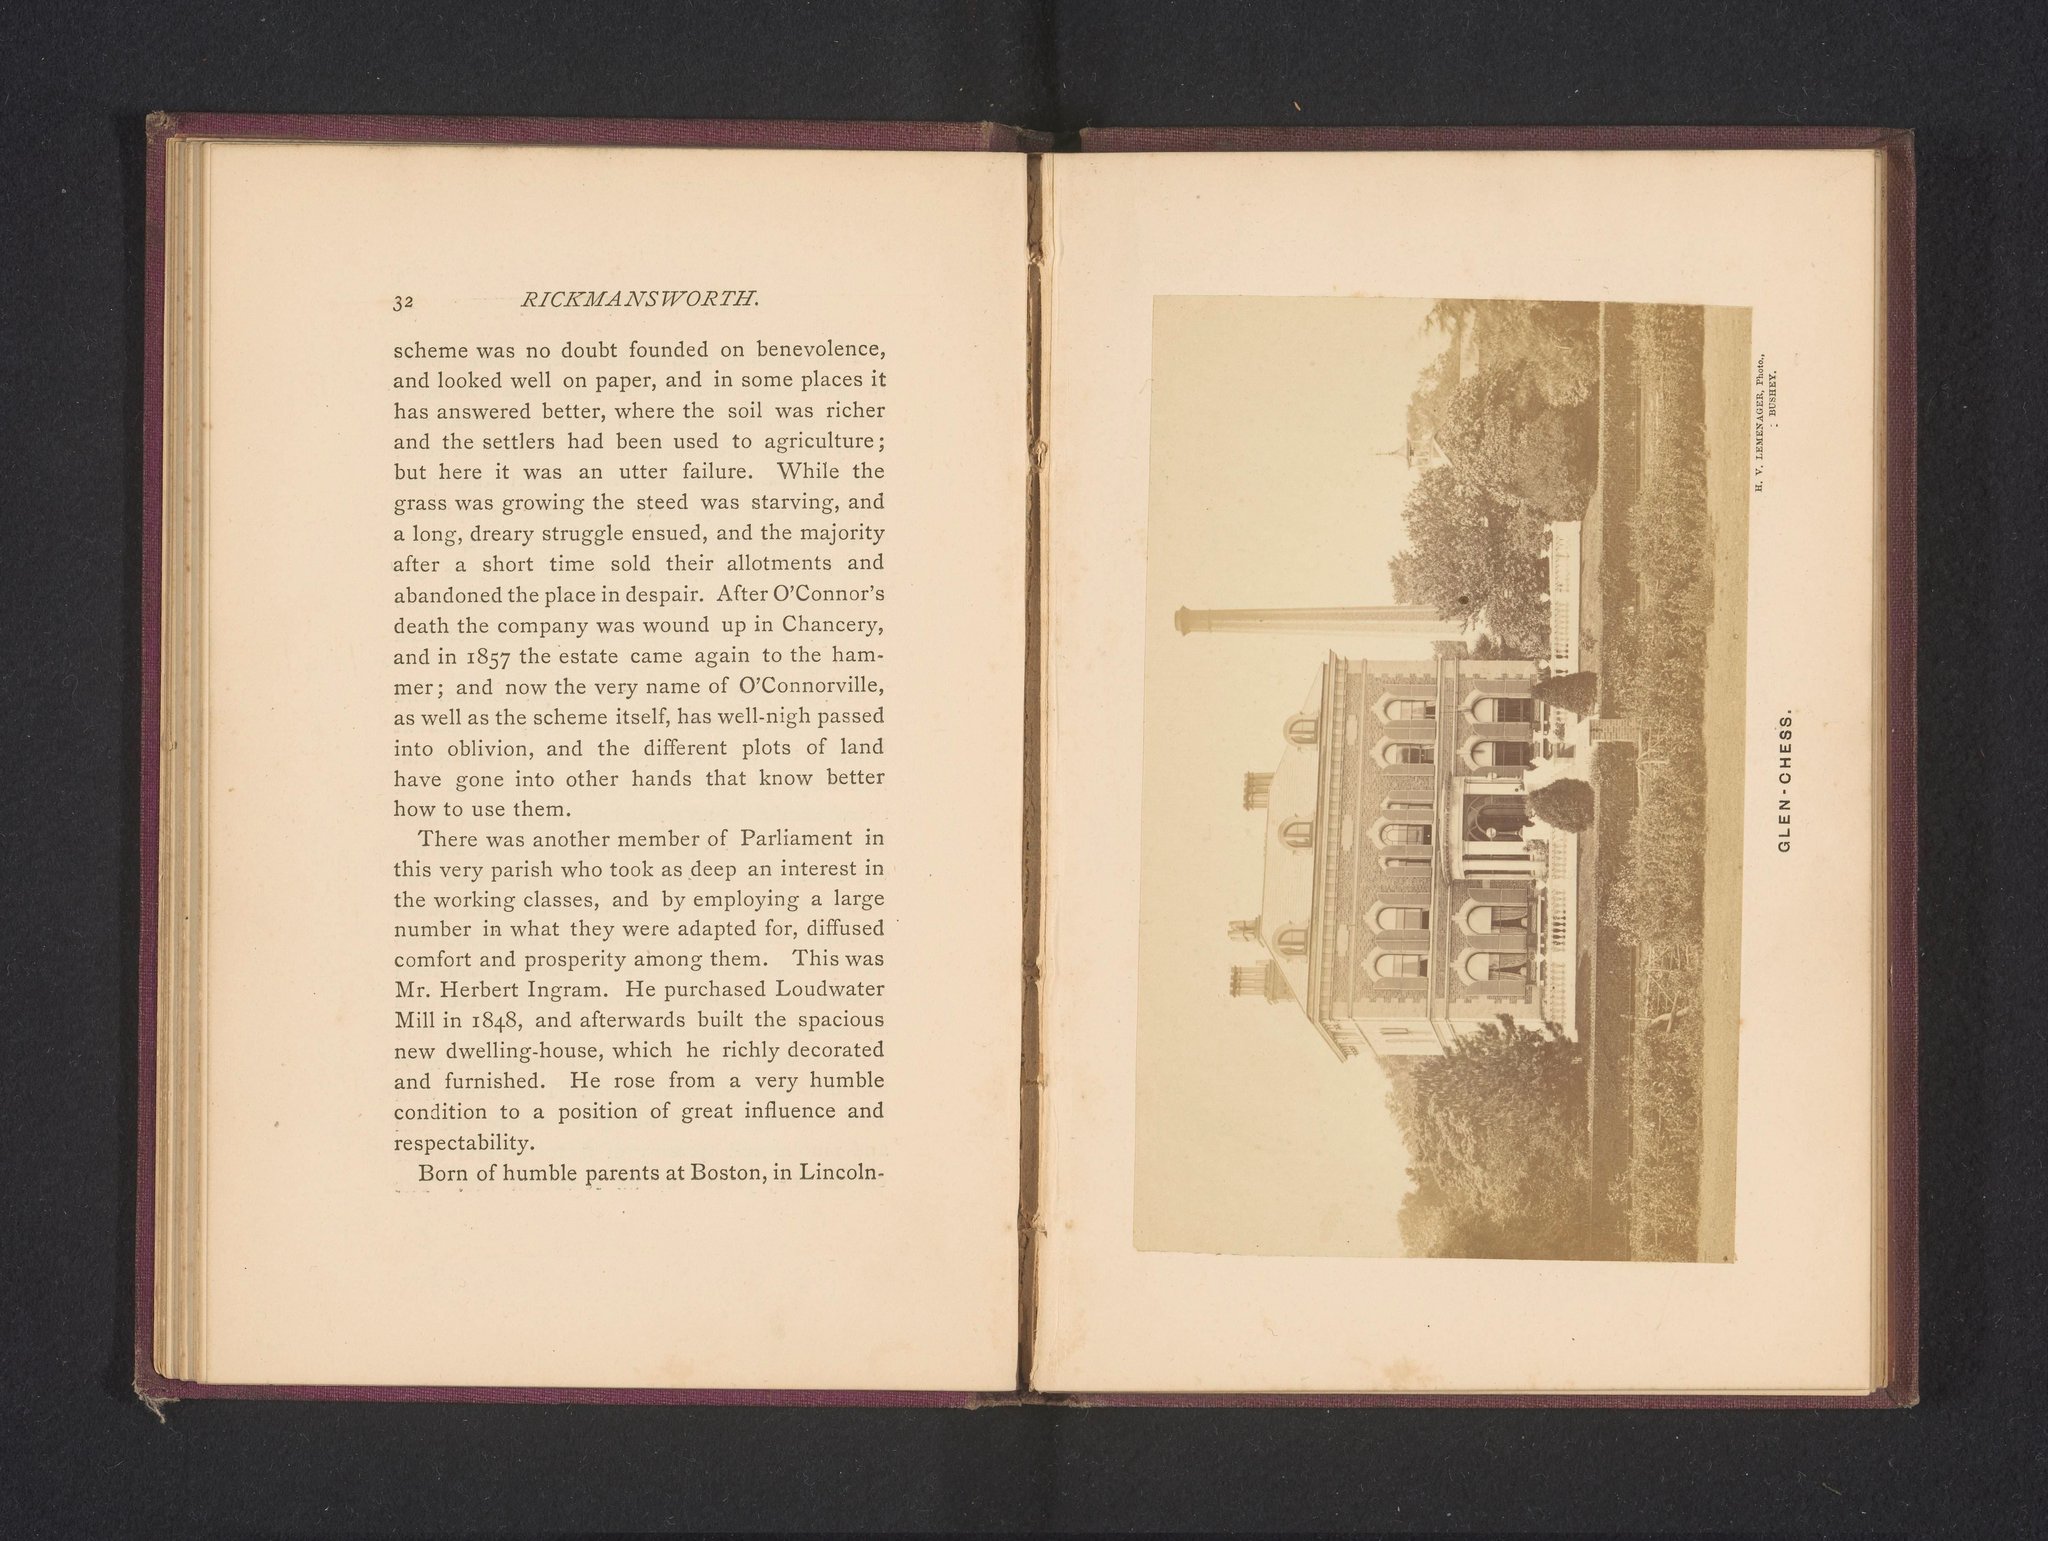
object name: page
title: Glem-Chess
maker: henri victor leménager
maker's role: docent, fotograaf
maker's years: 1822-1912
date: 1865-1870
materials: photographic support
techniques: albumen print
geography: rickmansworth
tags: city-view in general; 'veduta', civic architecture; edifices; dwellings